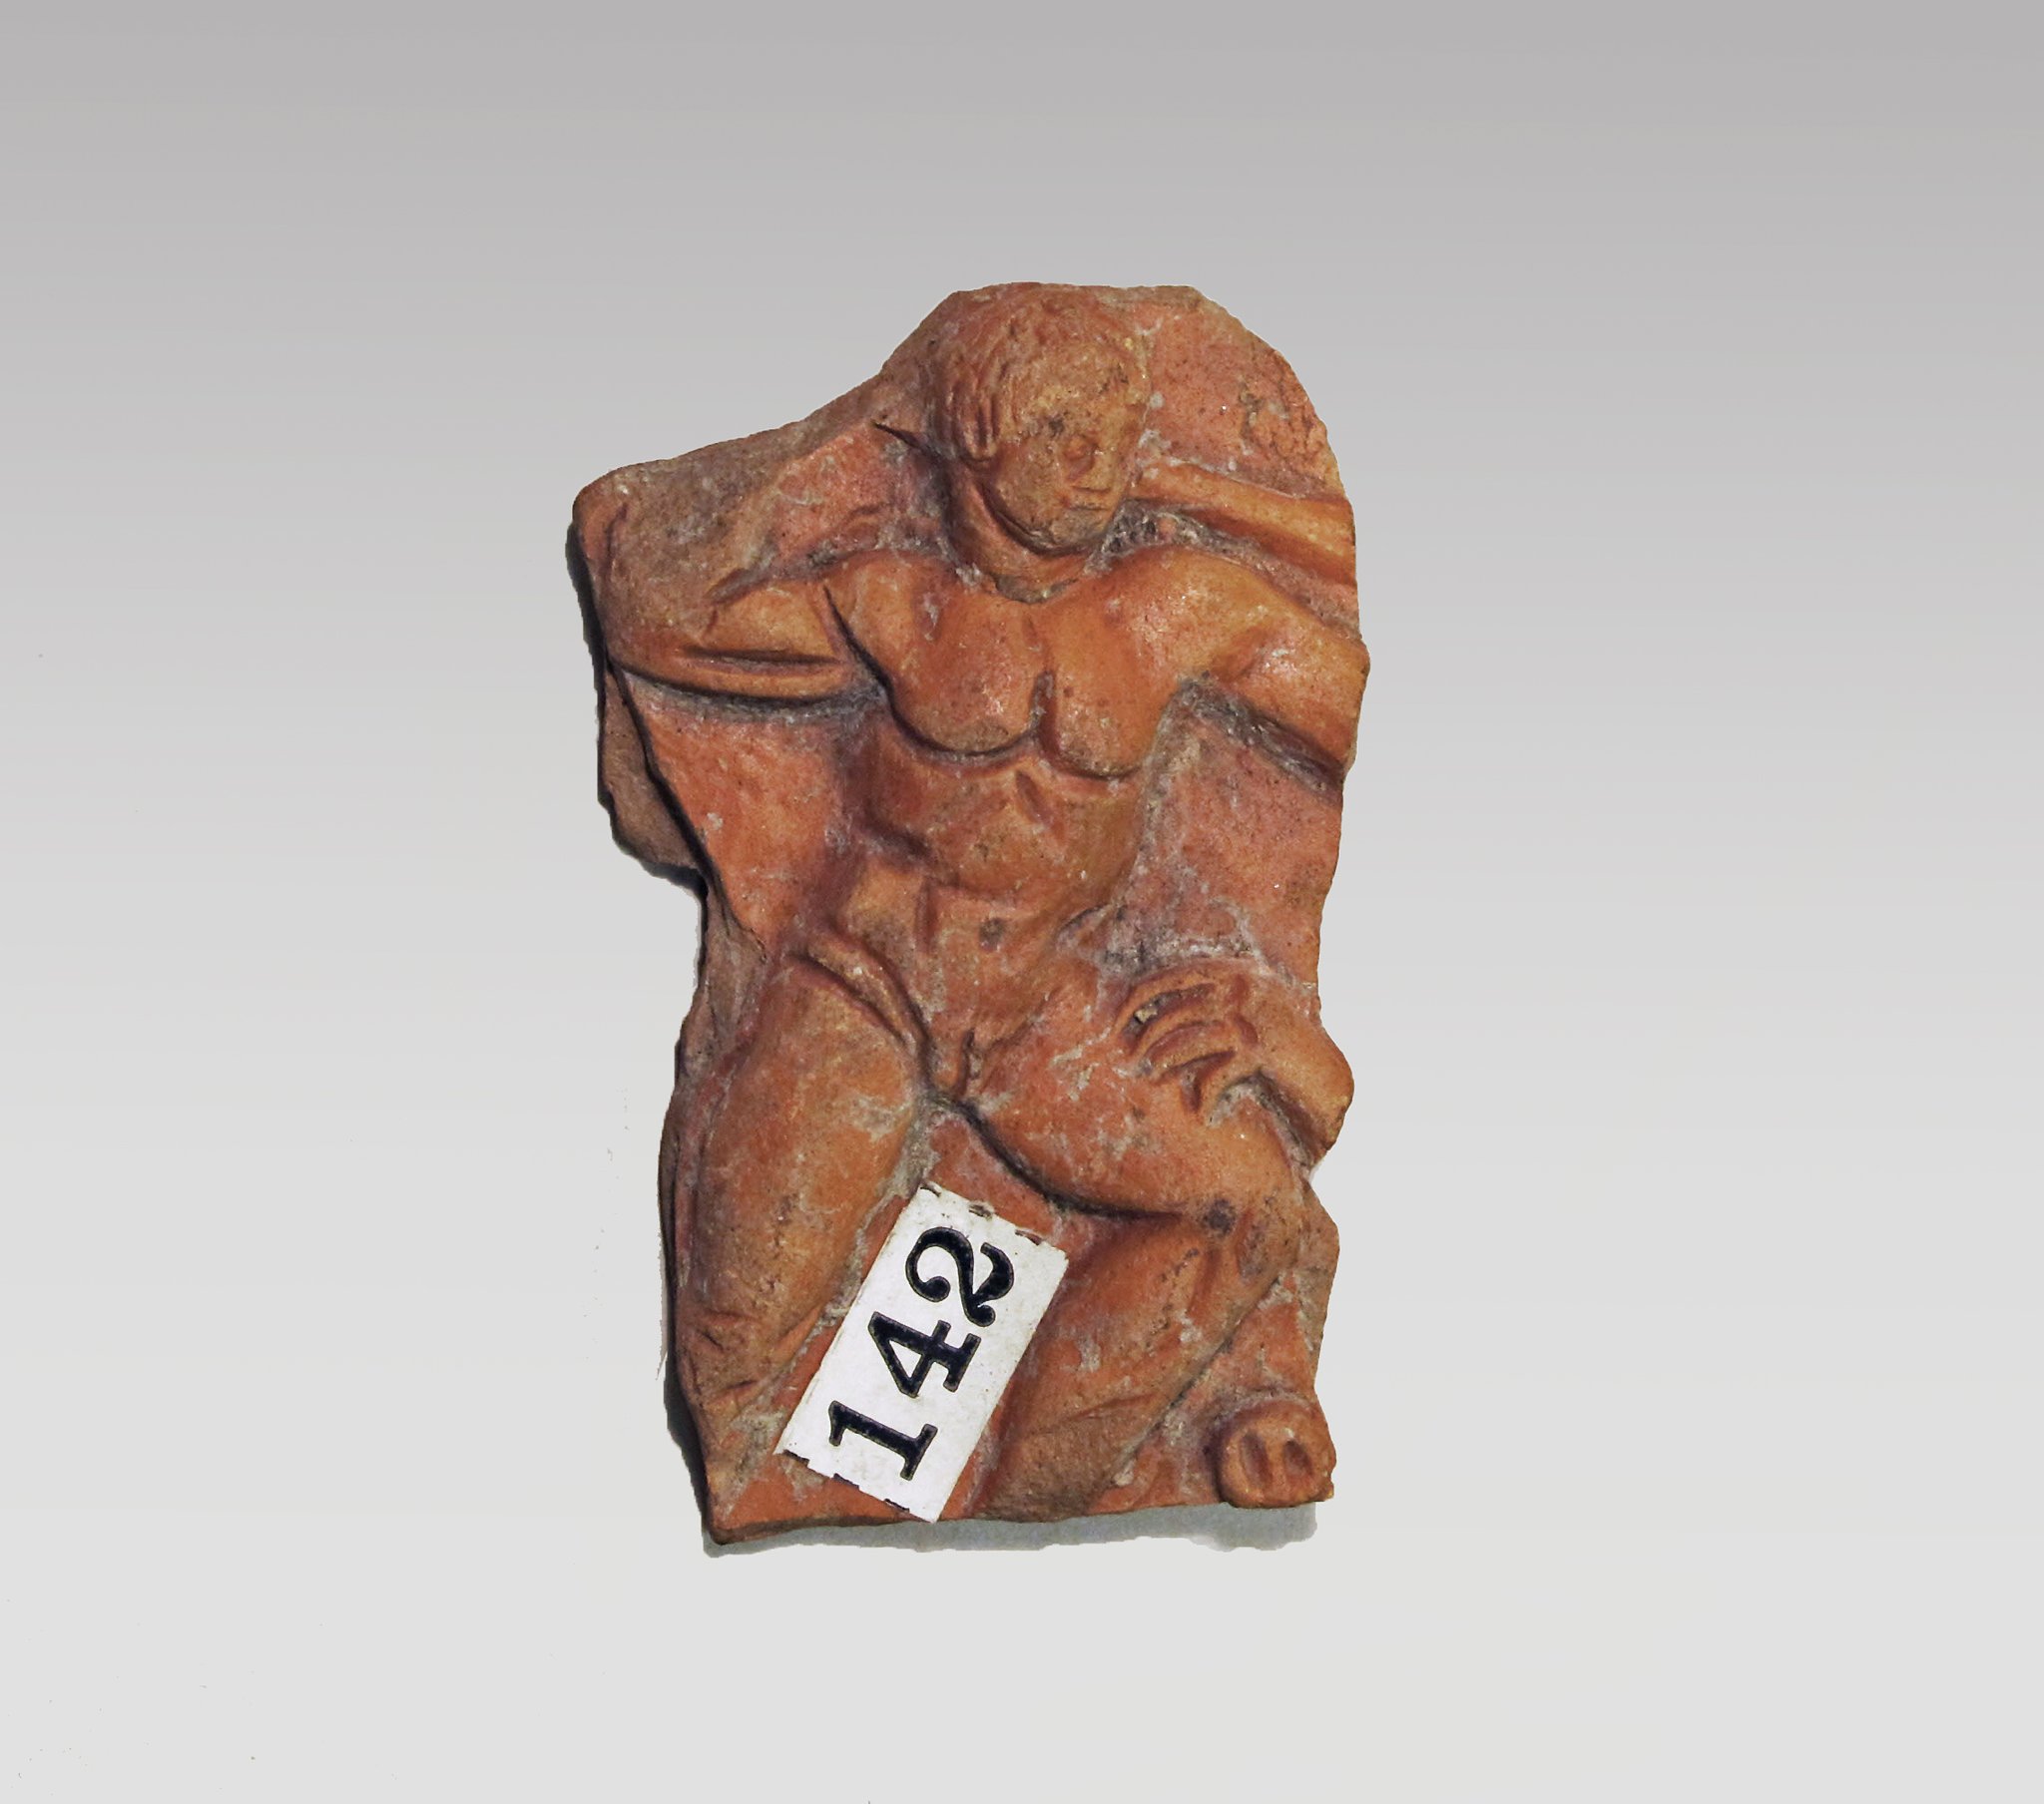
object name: vase fragment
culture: roman, gaul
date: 120 BCE-300 CE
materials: terracotta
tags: male nudes